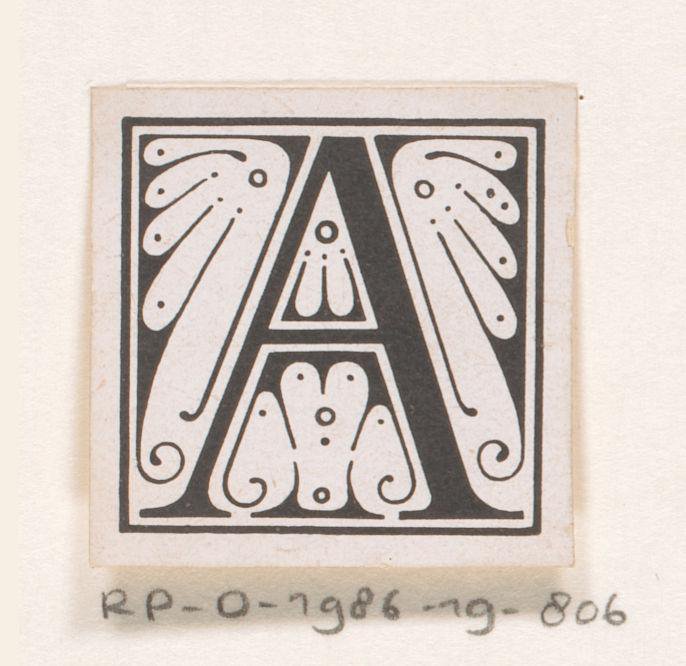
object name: photomechanical print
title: Initiaal A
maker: reinier willem petrus de vries (1874-1953)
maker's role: draughtsman, print maker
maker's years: 1874-1953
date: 1904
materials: paper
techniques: printing block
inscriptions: collector's mark: ‘R:MVS.’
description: Het initiaal is gebruikt voor: Veth, Jan. Jozef Israëls en zijn kunst. Arnhem en Nijmegen: Gebroeders E&M Cohen, 1904.